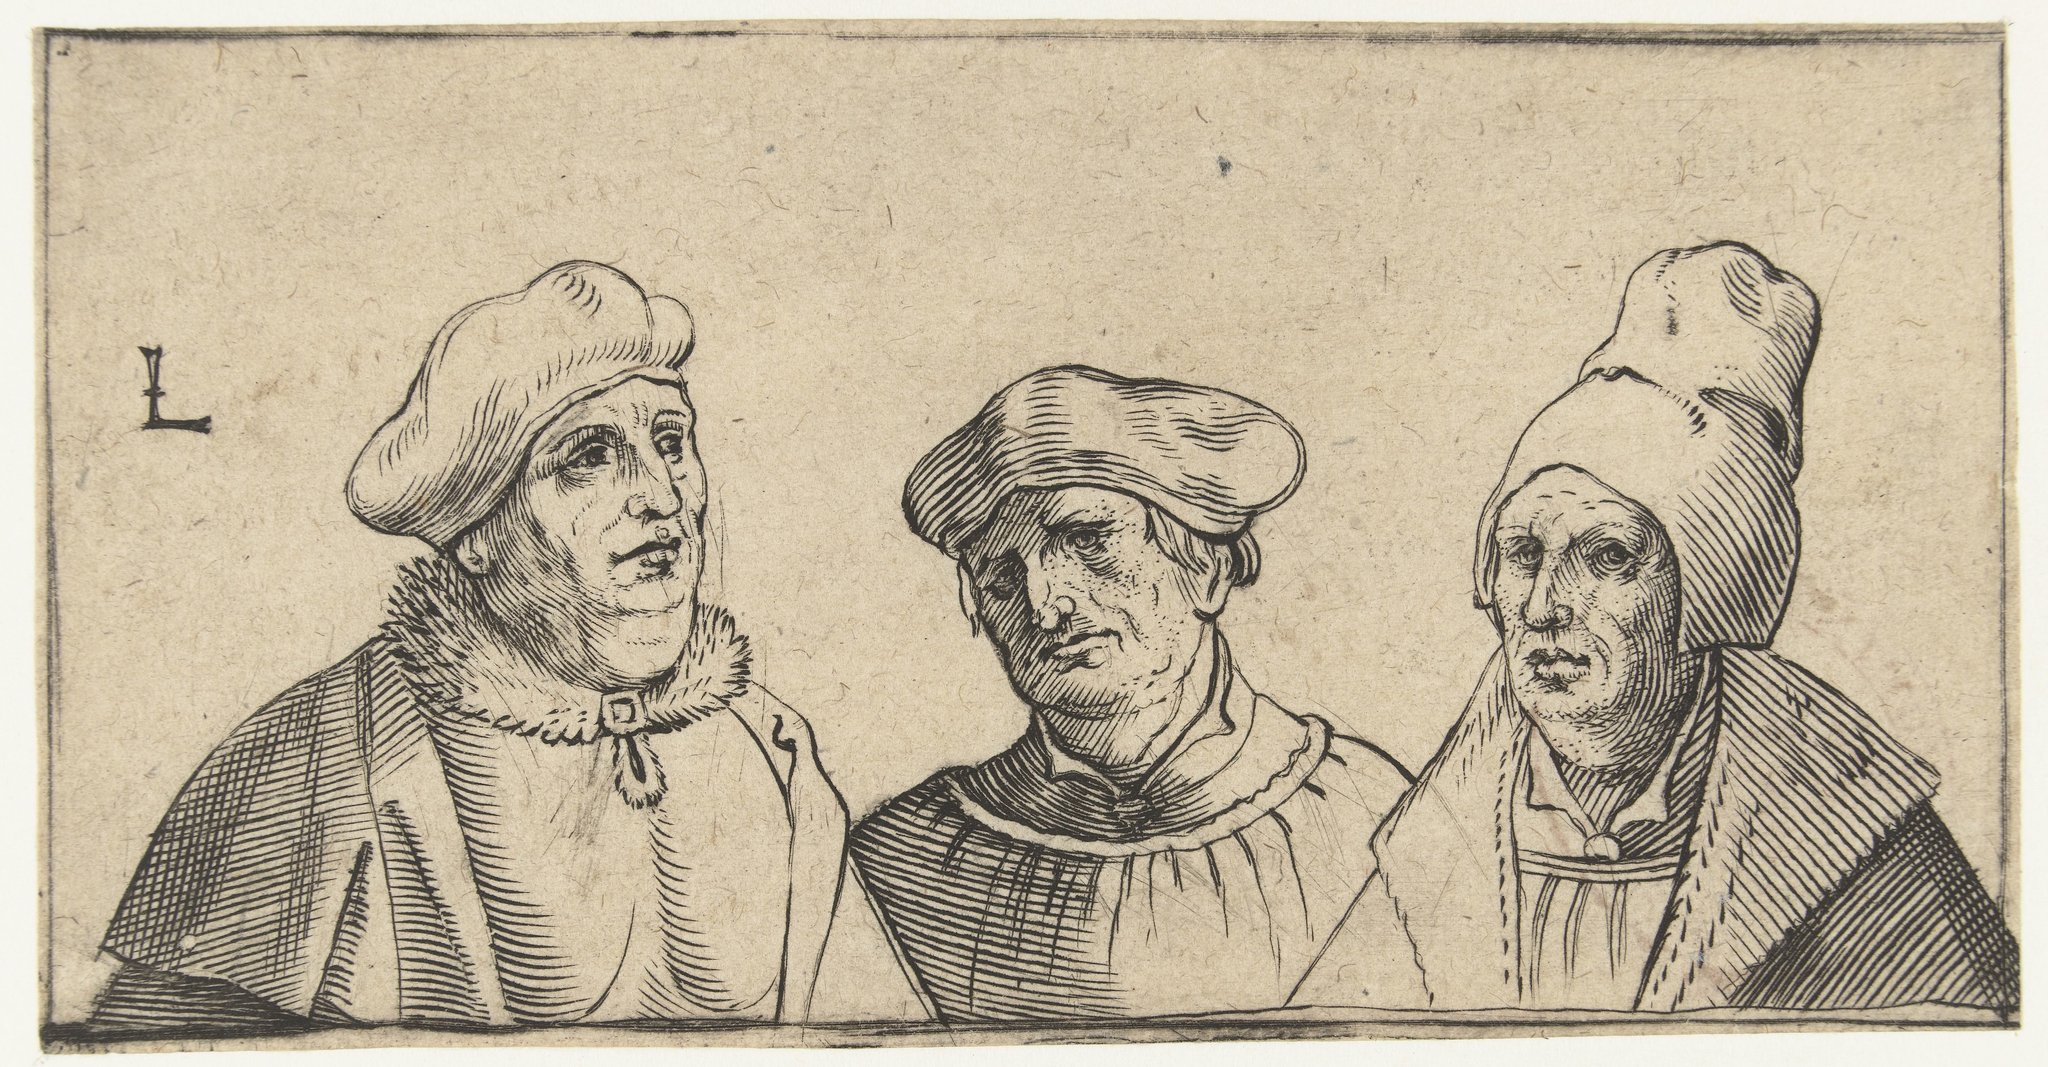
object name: print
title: Drie mansportretten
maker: Anonymous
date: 1500-1600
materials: paper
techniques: etching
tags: head-gear: beret (+ men's clothes), head-gear: cap (+ men's clothes), the (nude) human figure; 'corpo humano' (ripa) (+ three persons)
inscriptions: collector's mark: Lugt 240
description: Drie hoofden van mannen met verschillende hoofddeksels.